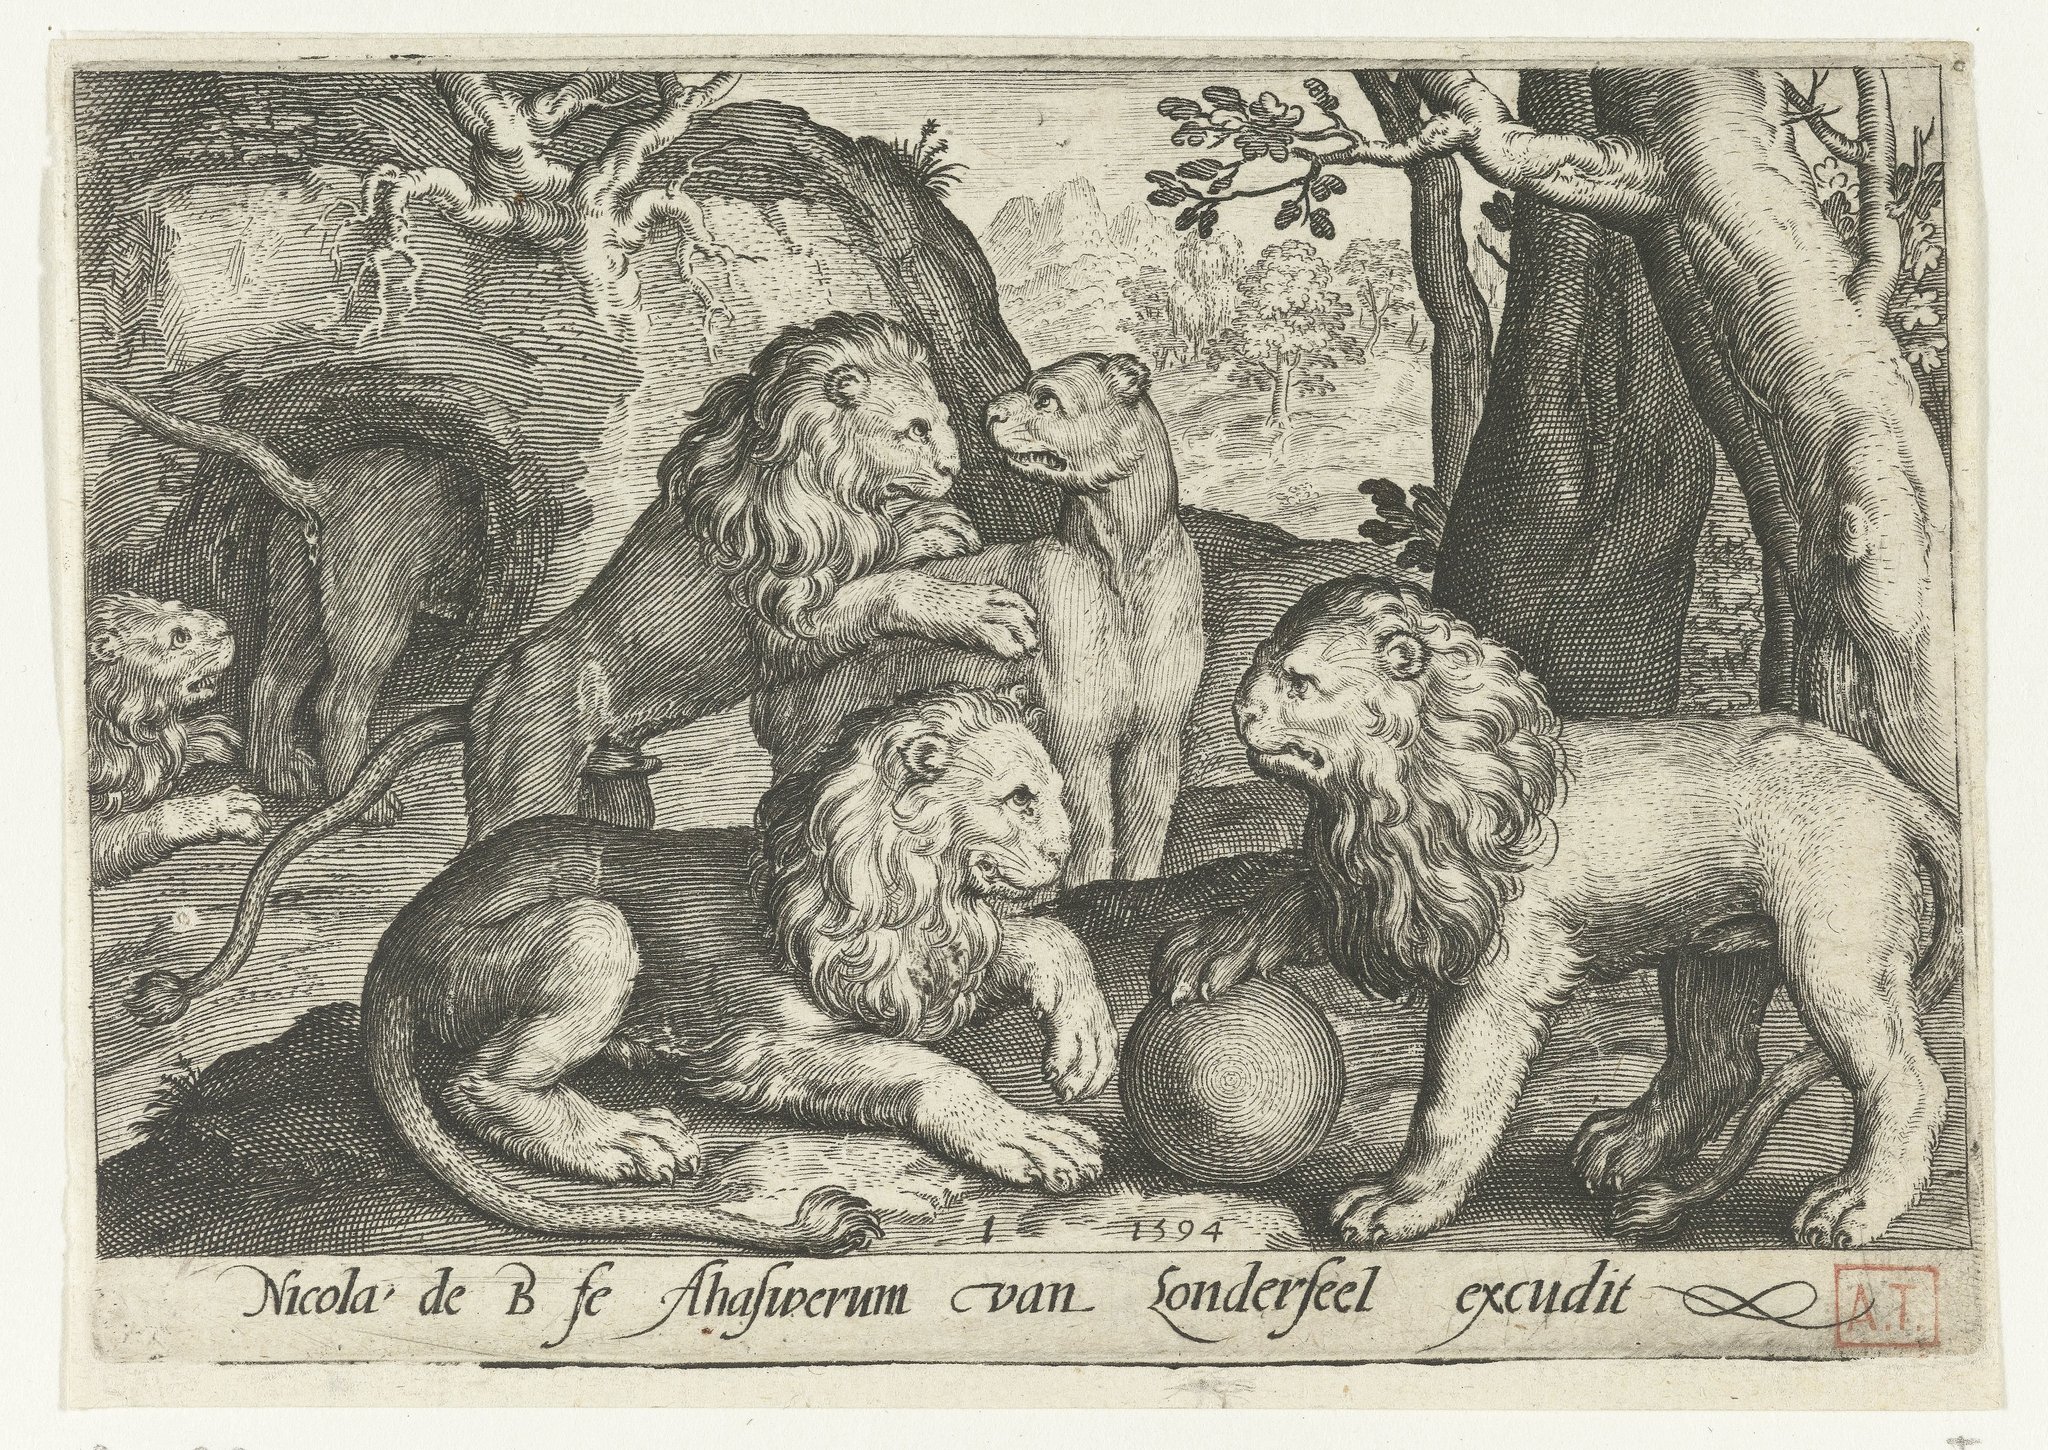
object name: print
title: Dieren in landschappen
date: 1594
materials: paper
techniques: engraving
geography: antwerp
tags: beasts of prey, predatory animals: lion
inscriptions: collector's mark: Lugt 184, collector's mark: Lugt 2228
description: Prent uit serie Animalivm qvadrvpedvm van twaalf prenten met dieren (viervoeters) in landschappen. Hollstein beschrijft twee staten, als eerste staat een uitgave van Assuerus van Londerseel voor de nummering (gedateerd 1594) en als tweede staat een uitgave van Claes Jansz. Visscher (II) met nummering (gedateerd 1621). Er is echter nog een andere editie bekend van uitgever Christoffel van Sichem welke tussen deze twee staten in geplaatst kan worden. Verschillende drukken van Visscher vertonen nog sporen van een adres van Van Sichem, op een enkel blad in de collectie van het RMA staat zijn adres, vergelijk RP-P-OB-16.158. De editie van Visscher is gedrukt van zeer versleten platen, zie De Groot 1988, p. 36, 37.